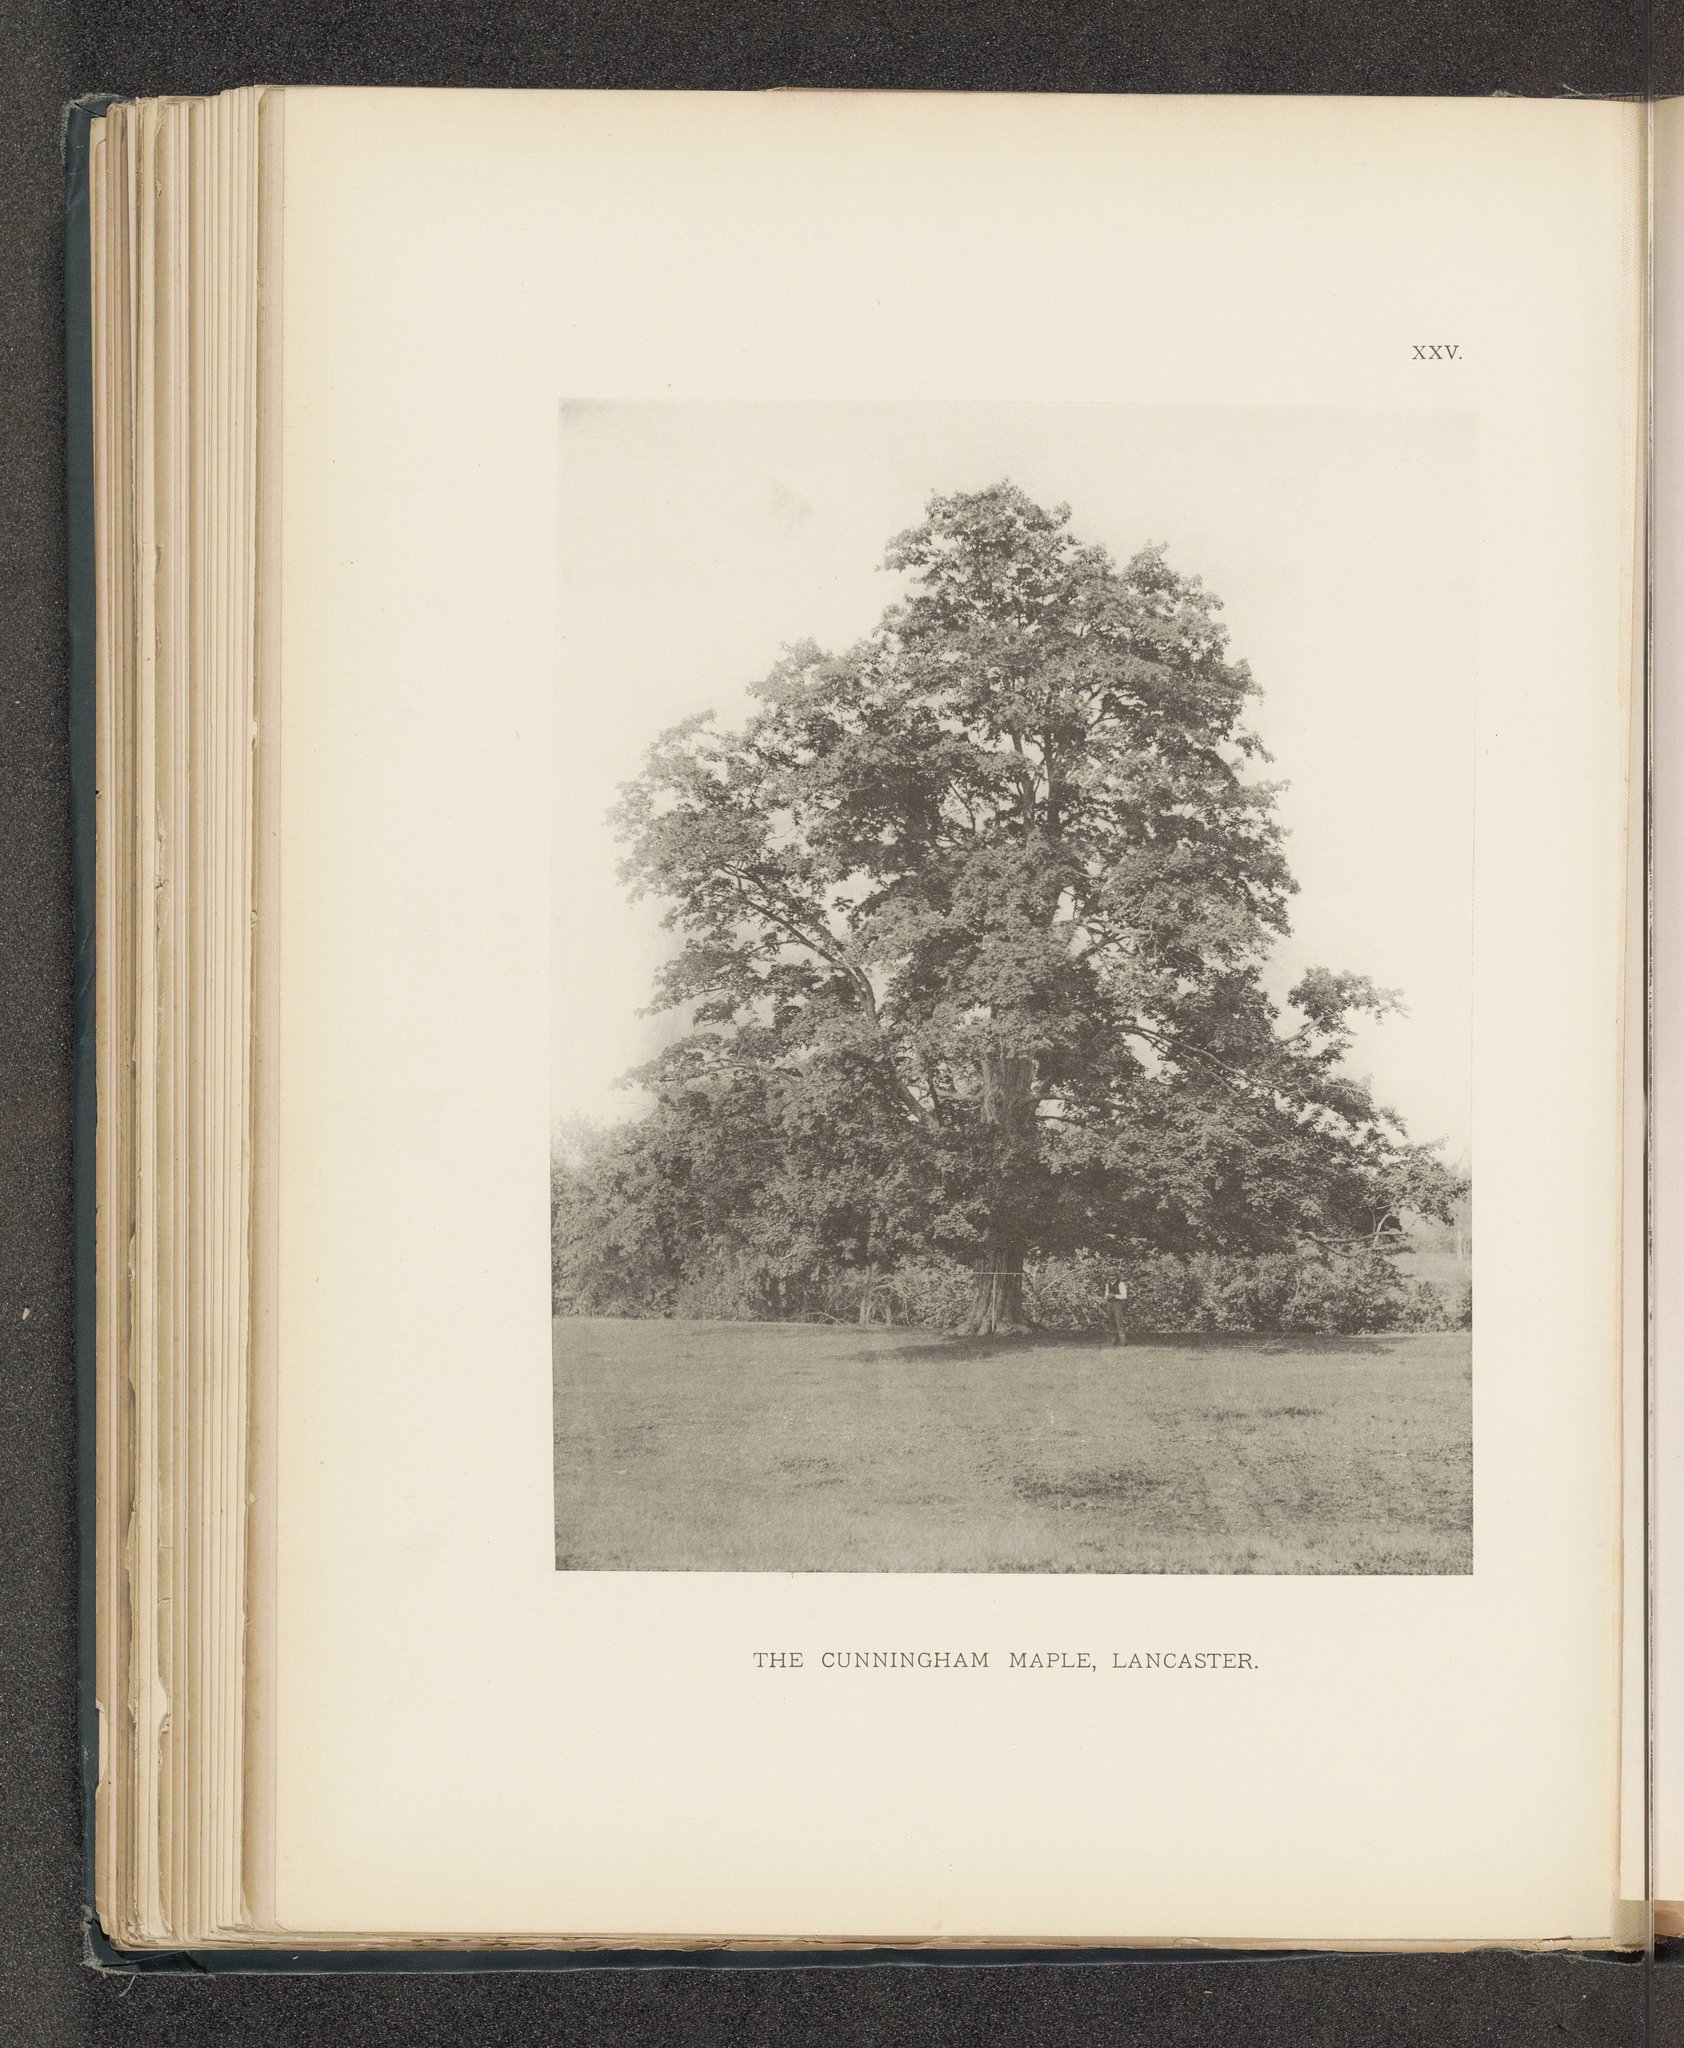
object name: page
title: The Cunningham maple, Lancaster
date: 1880-1890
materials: paper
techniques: photograph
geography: united states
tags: trees: acer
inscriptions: number: ‘XXV.’